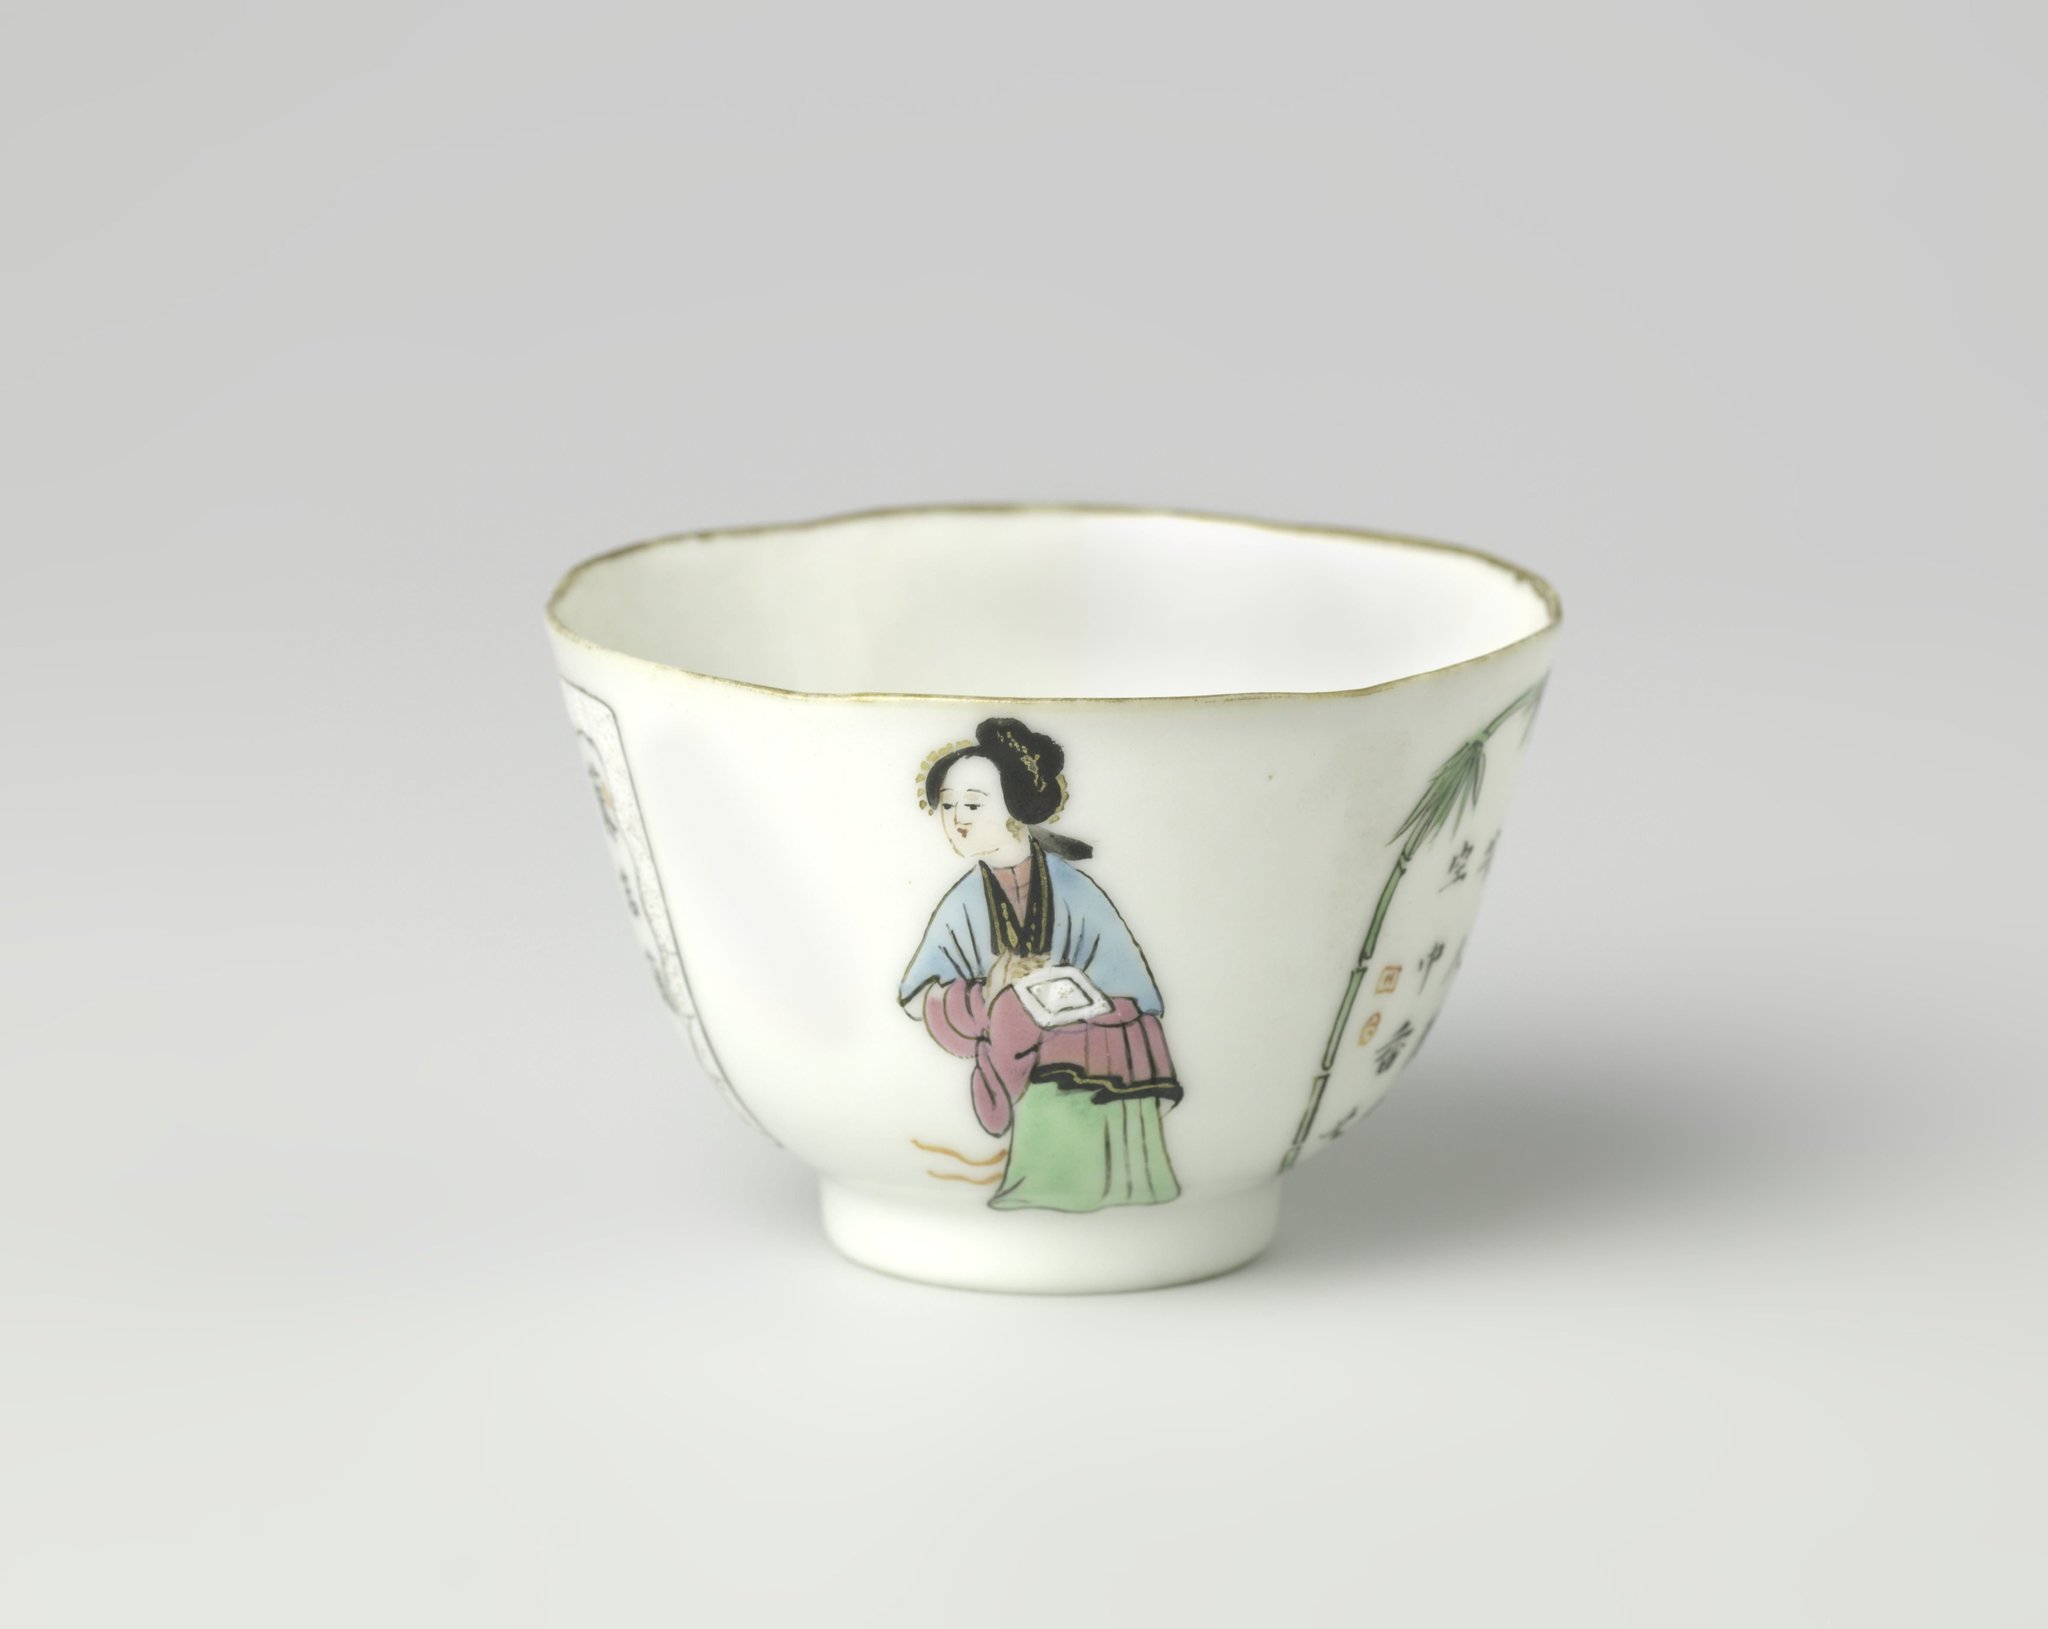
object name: kop en schotel, kop en schotel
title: Cup with a man, woman and two panels with characters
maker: Anonymous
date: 1825-1874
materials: glaze, gold, paint, porcelain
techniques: firing, gilding, turning, vitrification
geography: china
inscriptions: inscription